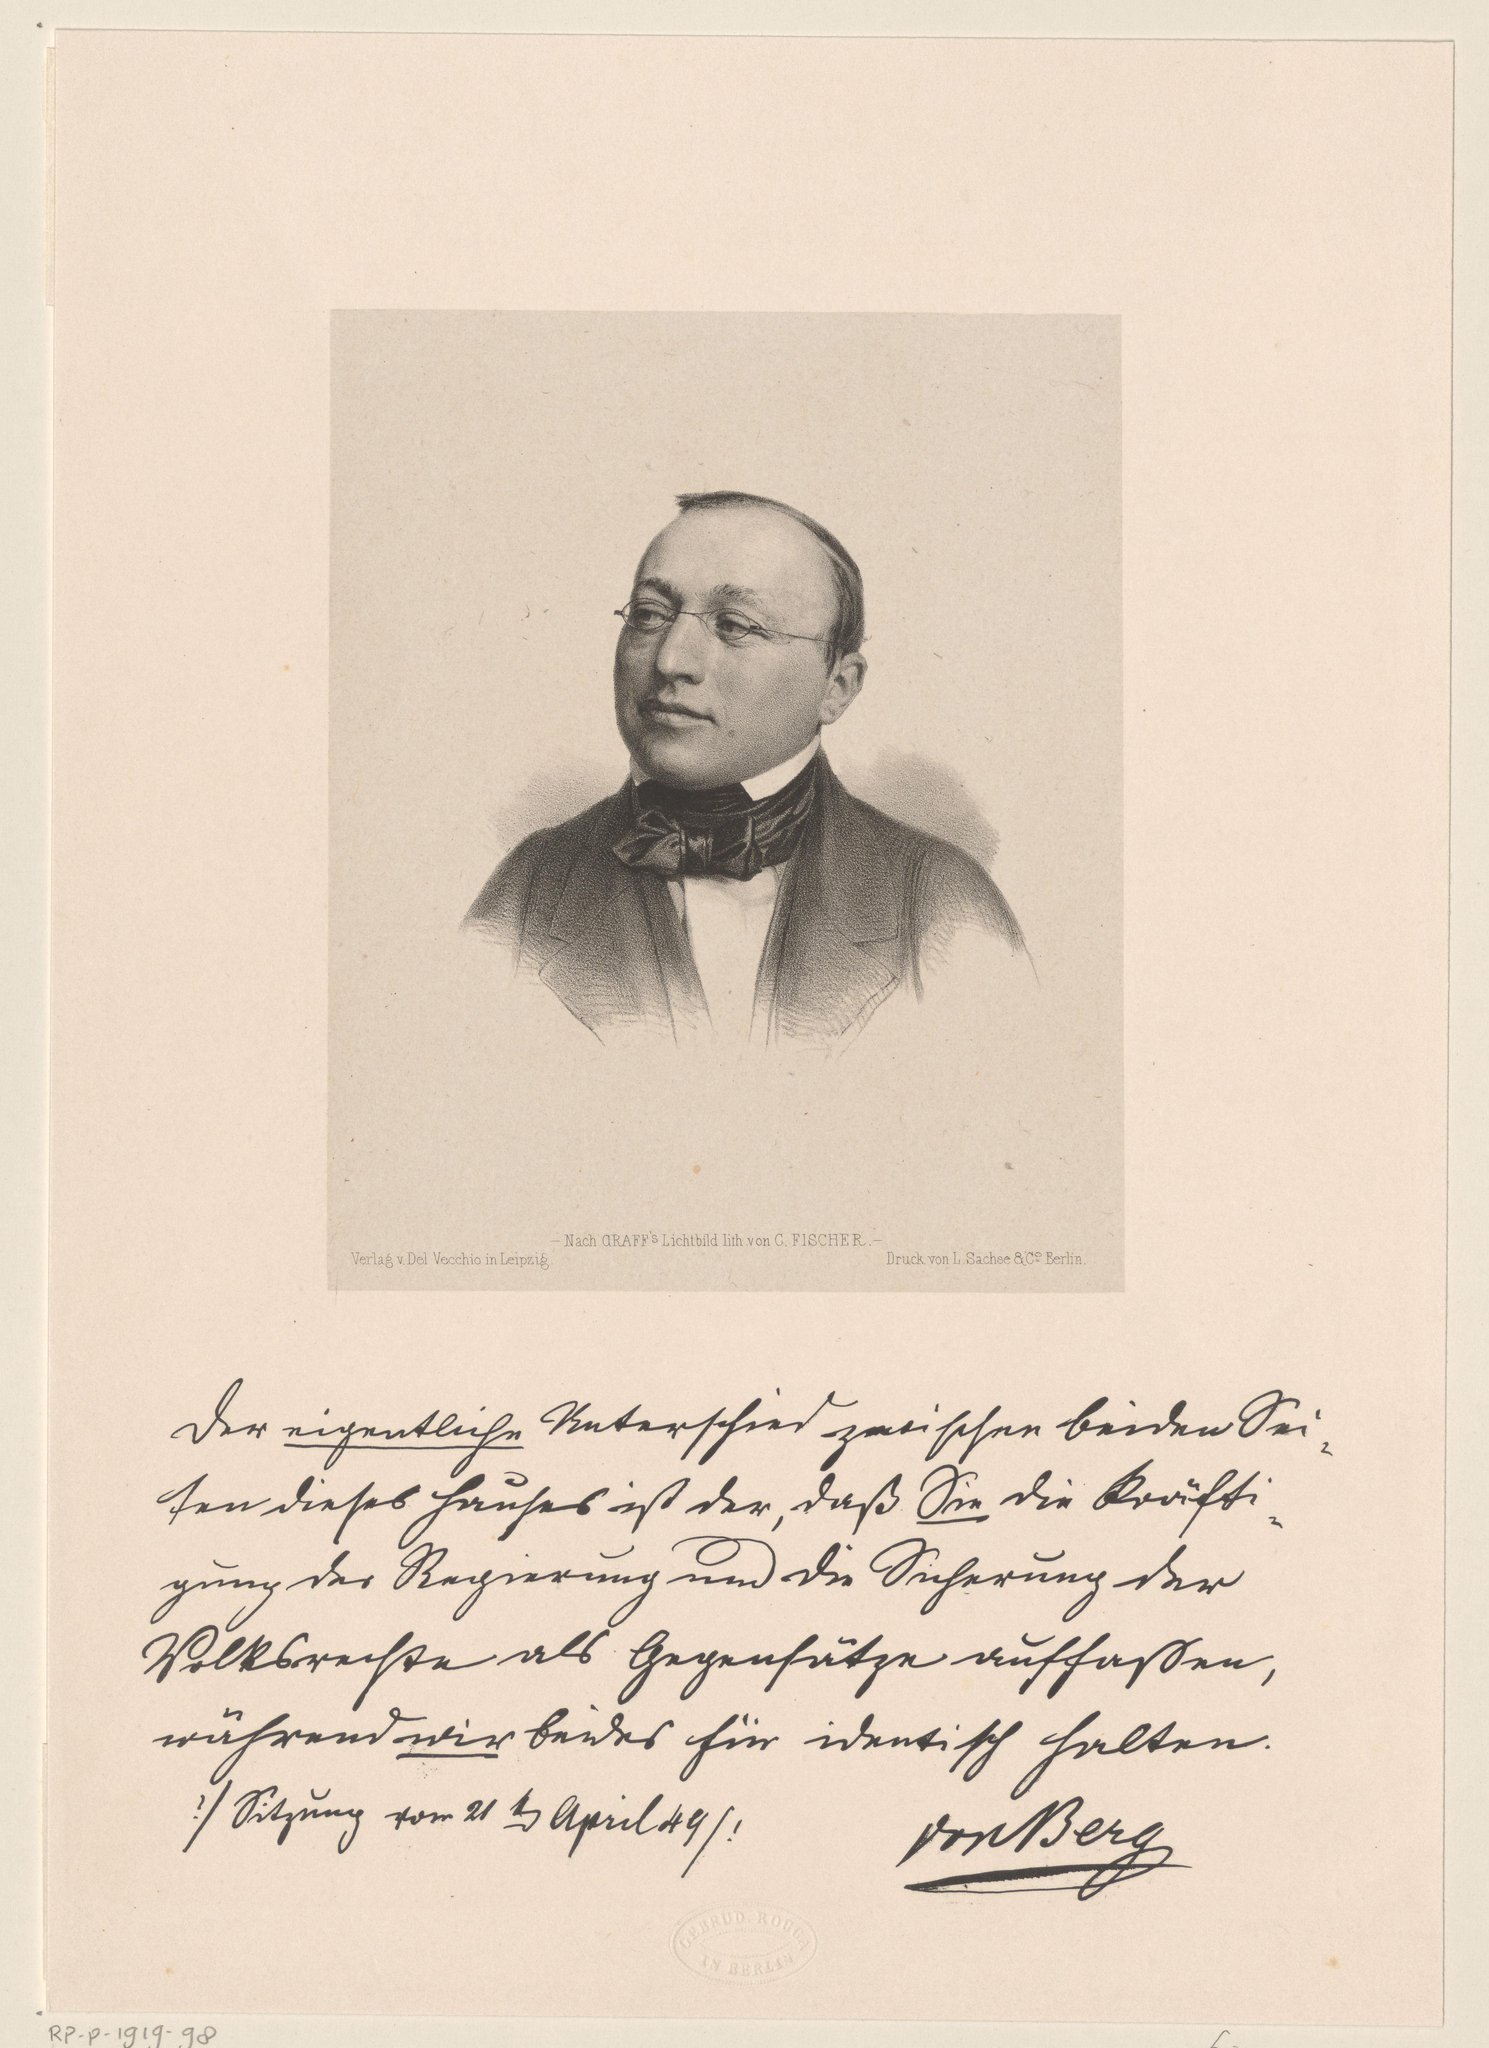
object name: print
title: Portret van mogelijk Hermann von Berg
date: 1849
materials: paper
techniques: lithograph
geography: berlin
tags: politician, historical persons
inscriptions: workshop stamp: Lugt 2141c, collector's mark: Lugt 2228